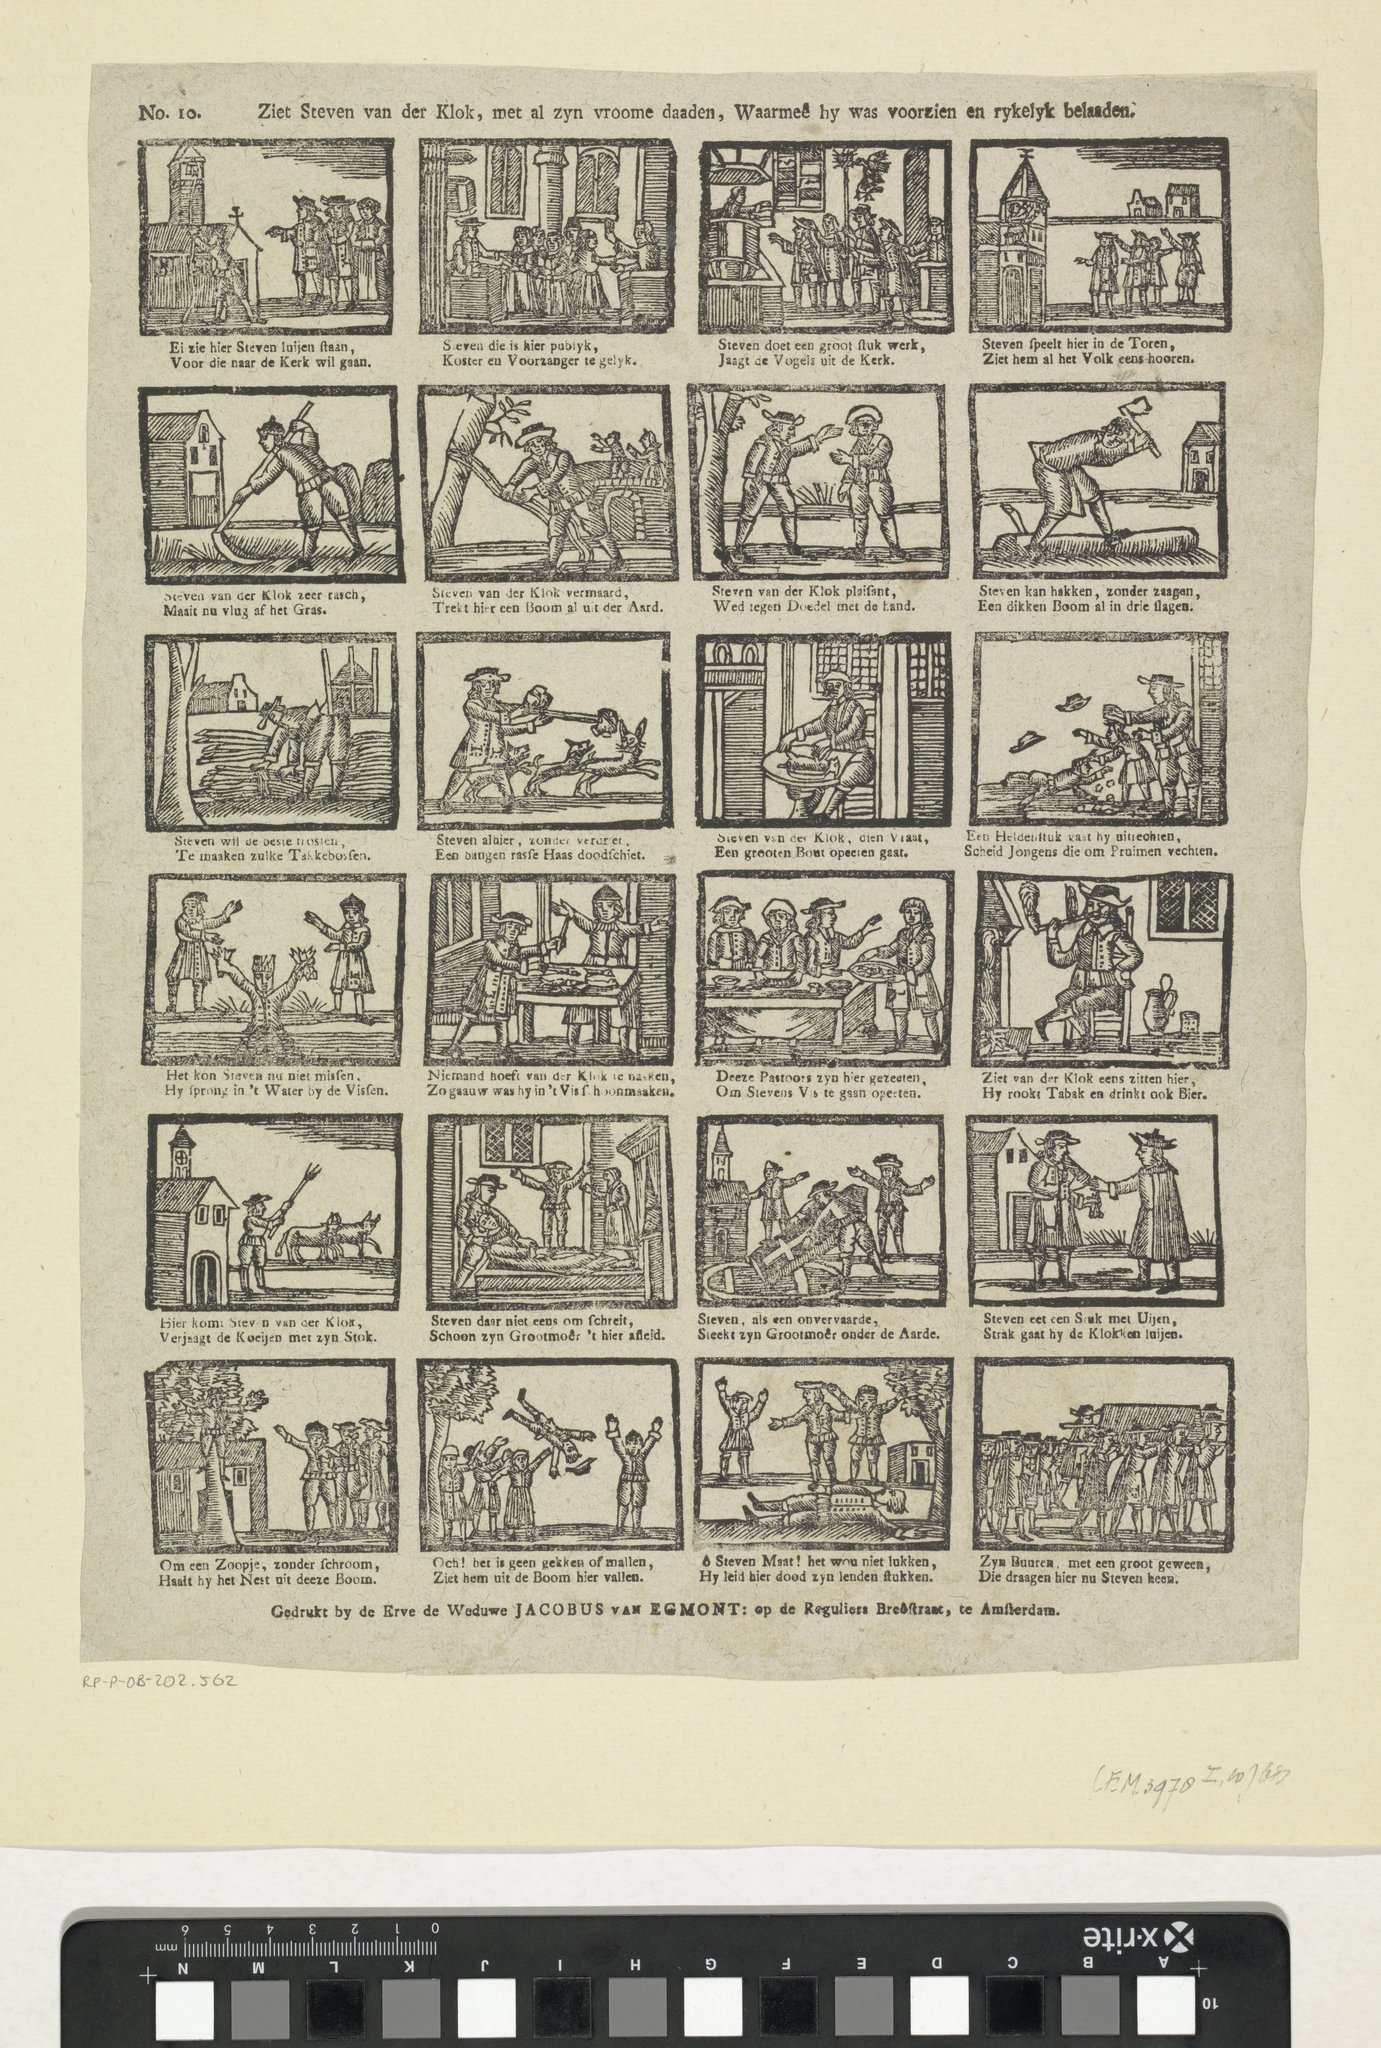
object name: popular print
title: Ziet Steven van der Klok, met al zyn vroome daaden, Waarmeê hy was voorzien en rykelyk belaaden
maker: Anonymous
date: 1761-1804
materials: paper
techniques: letterpress printing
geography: amsterdam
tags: death by accident (non-violent death), funerary ceremonial, tales and fairy tales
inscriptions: collector's mark: Lugt 2760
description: Blad met 24 voorstellingen over het leven van Steven van der Klok. Onder elke afbeelding een tweeregelig vers. Genummerd linksboven: No. 10.